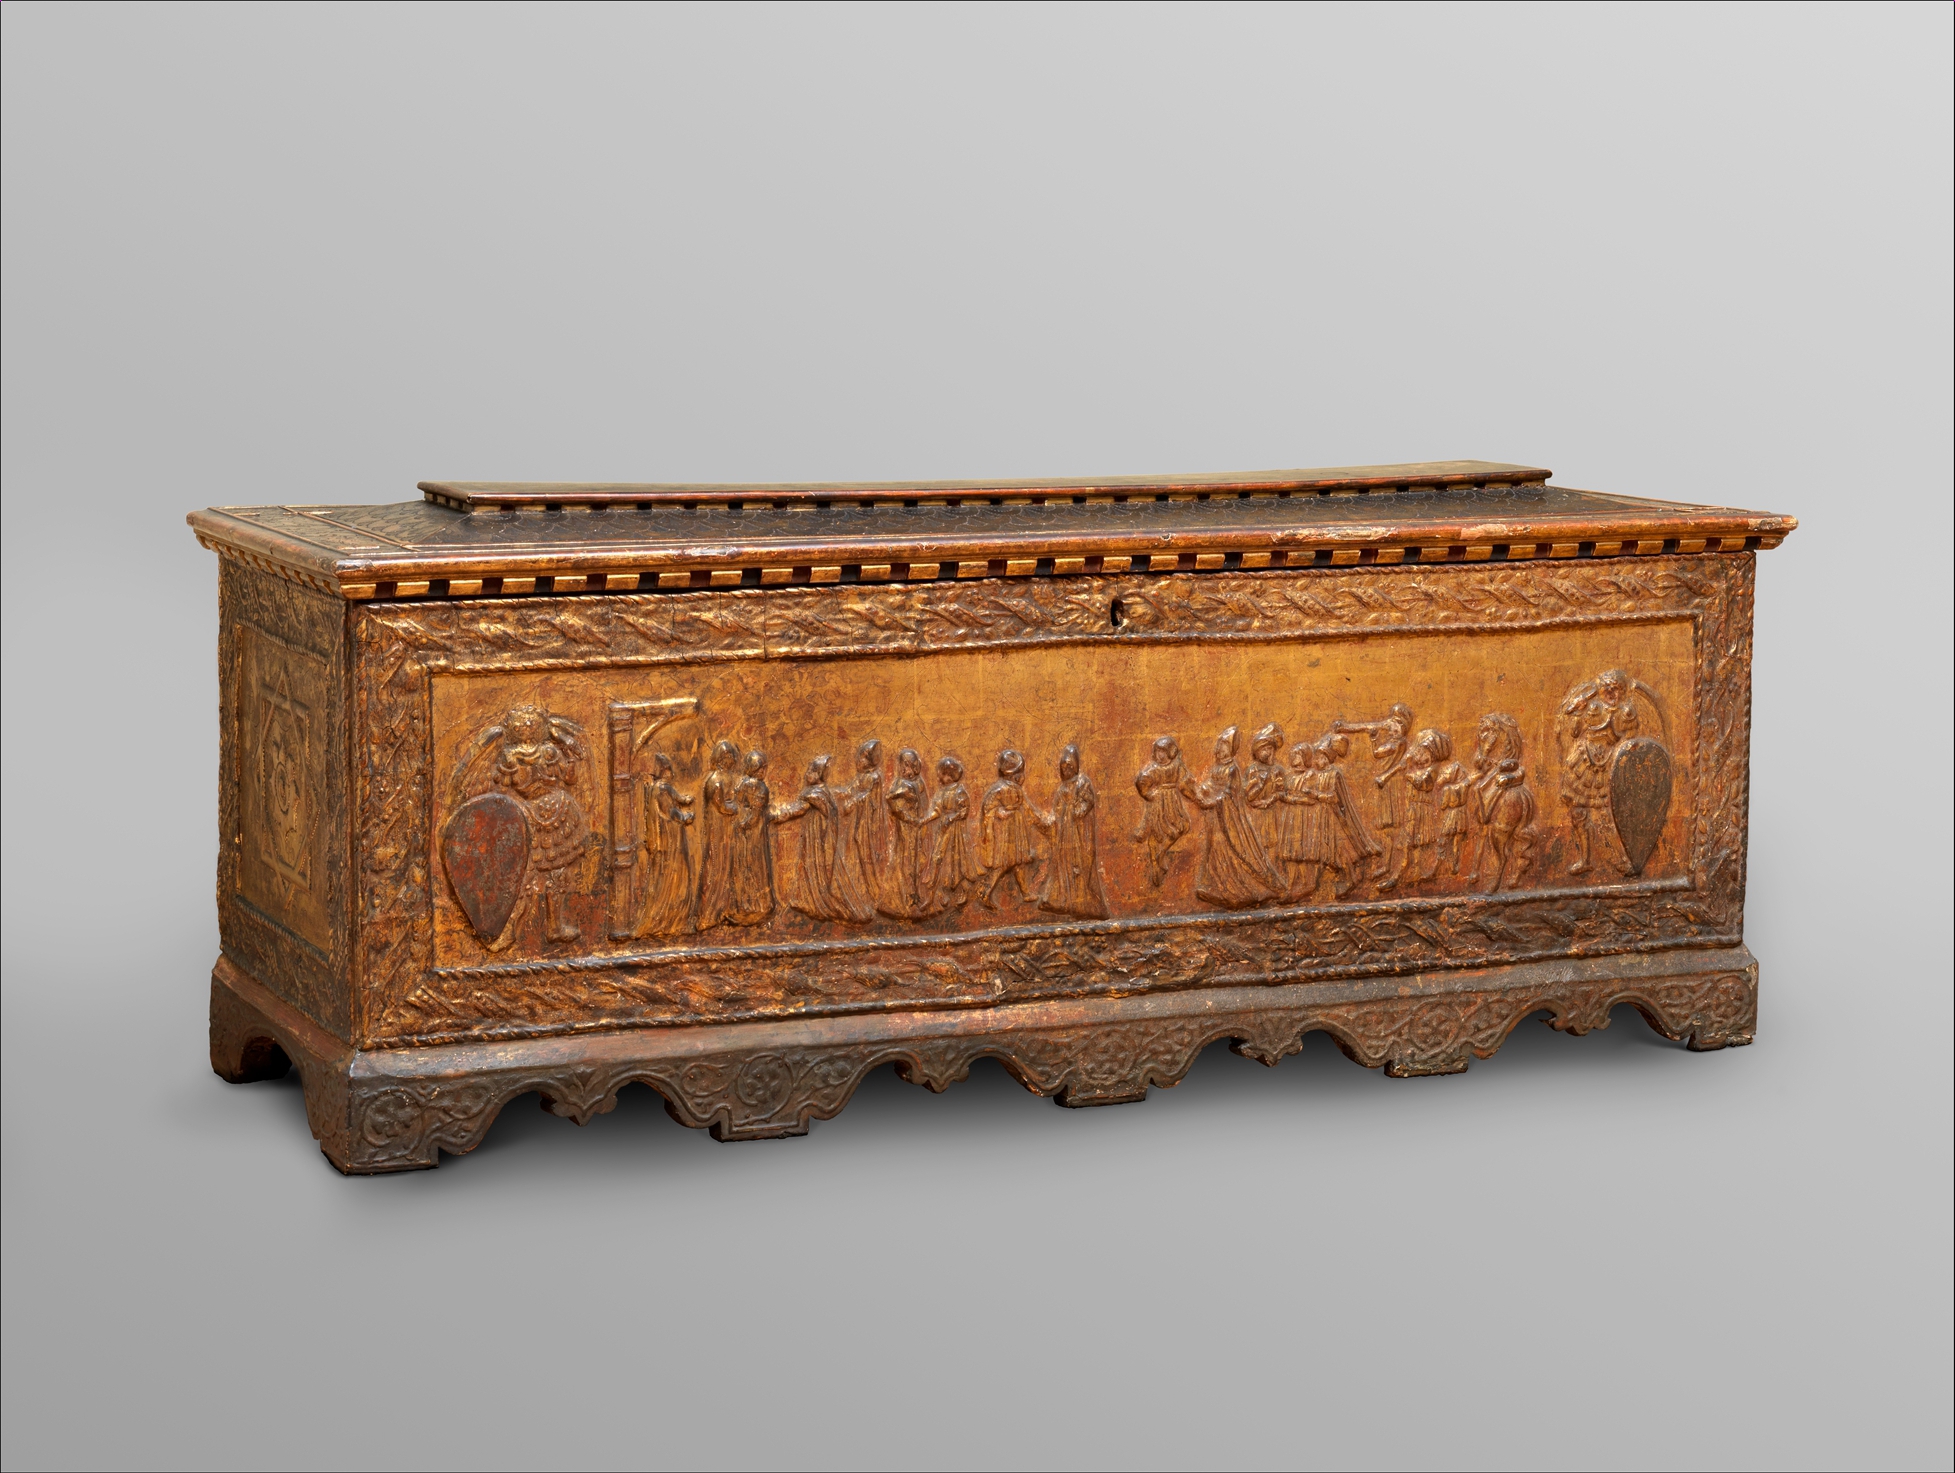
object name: cassone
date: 1434-1466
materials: wood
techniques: gilding, painting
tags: weddings,processions